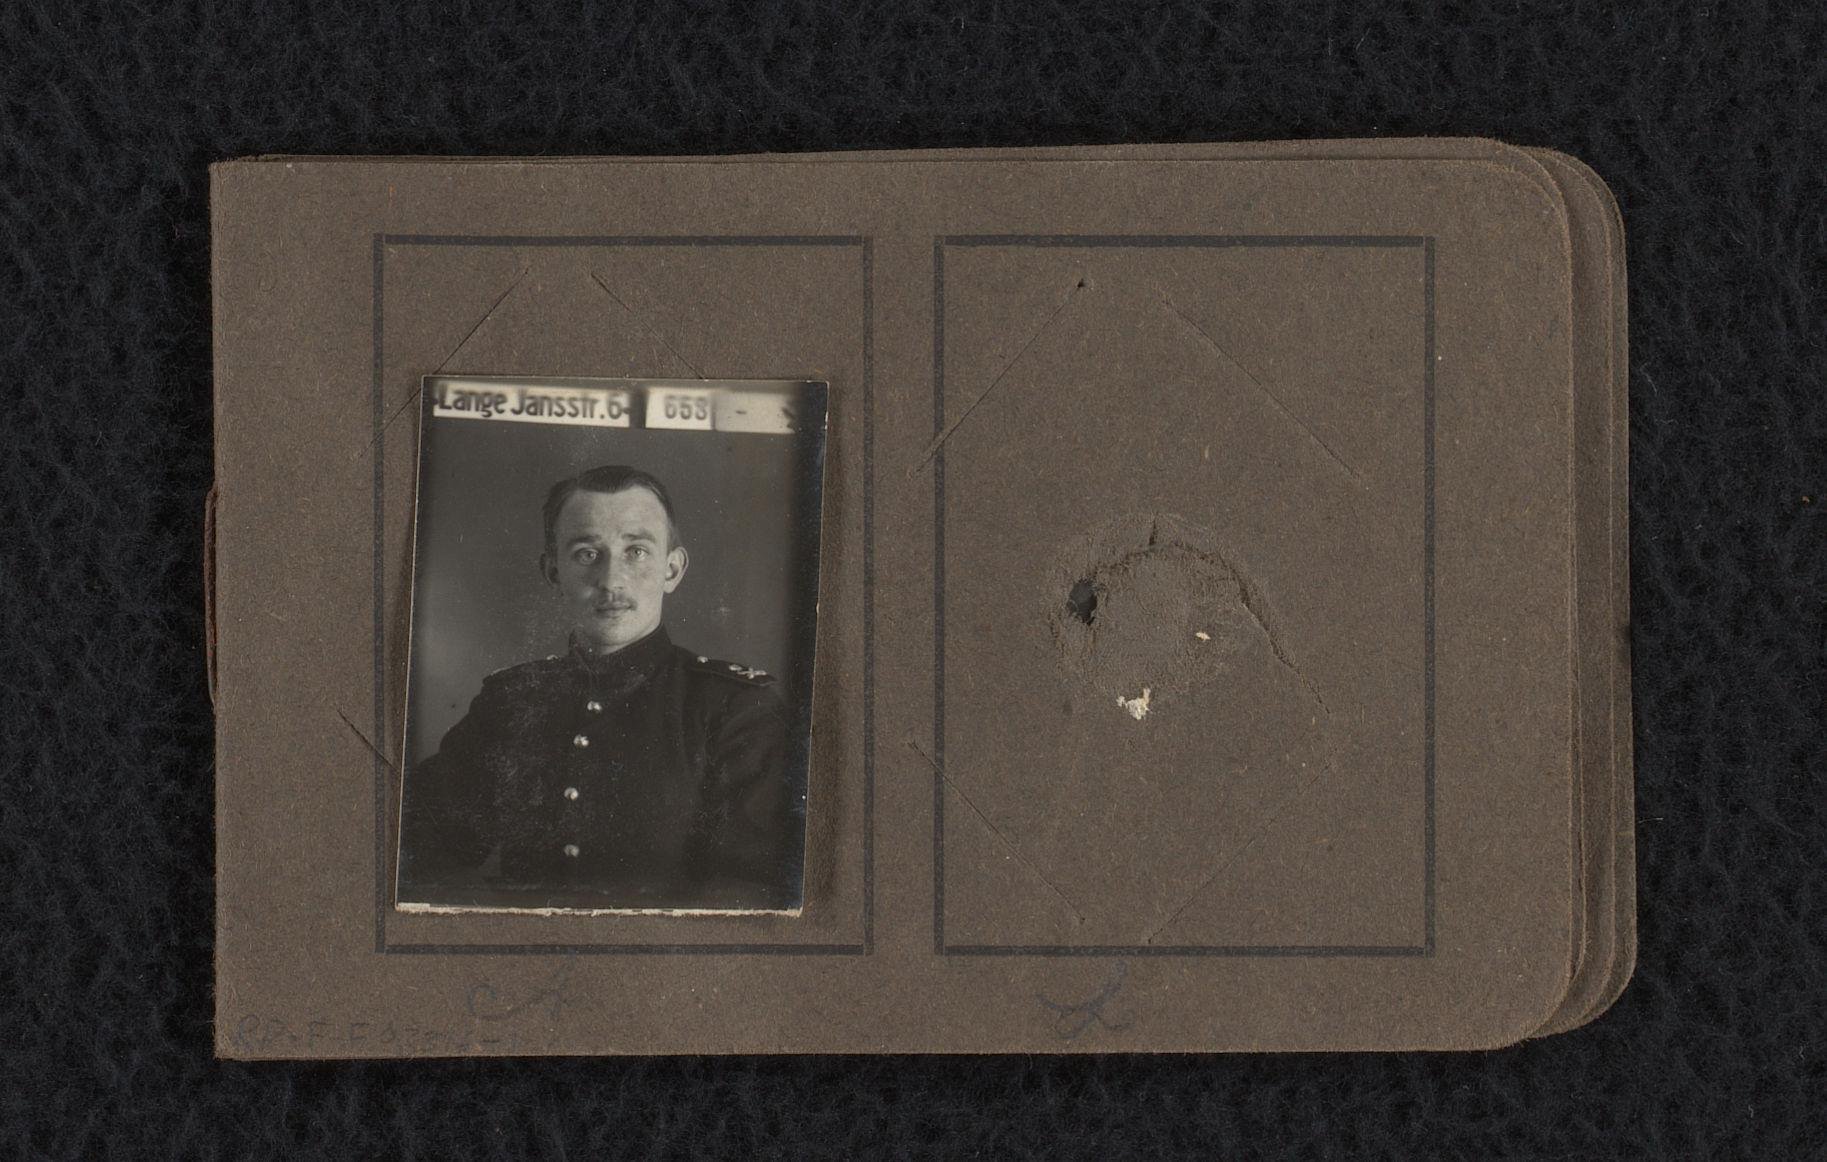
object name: snapshot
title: Fotoalbum met snelfoto's uit Utrecht en Leeuwarden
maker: Anonymous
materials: paper, cardboard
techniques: gelatin silver print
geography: leeuwarden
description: Fotoalbum met 8 bladen met 29 snelfoto's uit Utrecht en Leeuwarden, waarvan 9 los.